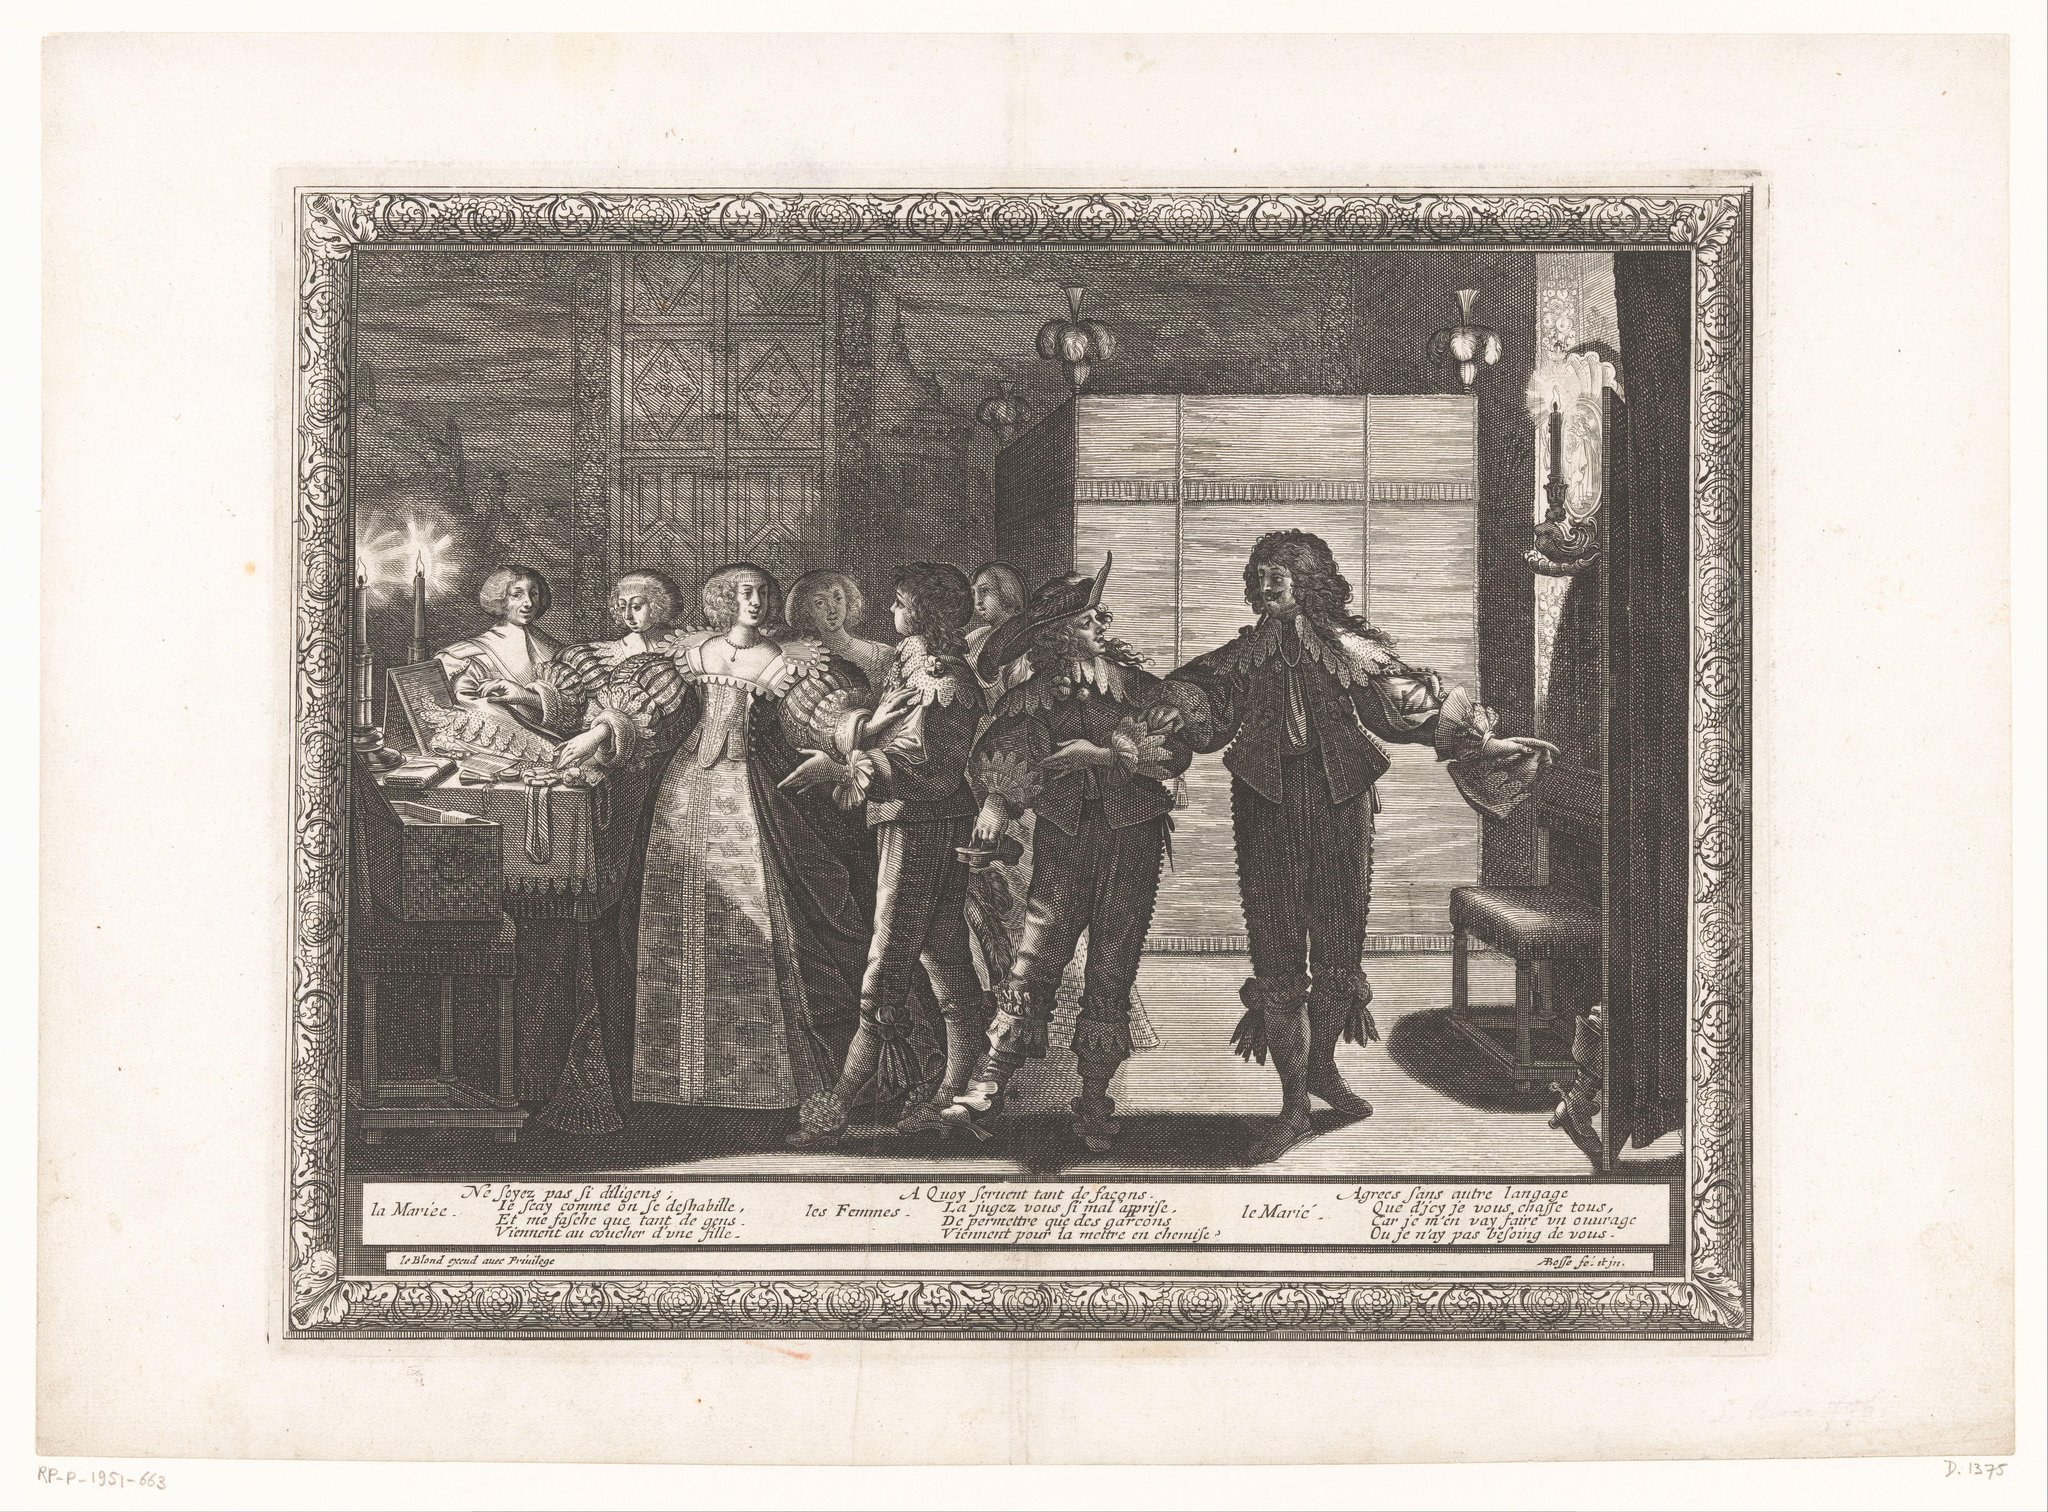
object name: print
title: Le Mariage à la ville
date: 1633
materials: paper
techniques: engraving, etching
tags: (civil) marriage ceremonies, leading the bride to bed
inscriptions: collector's mark: Lugt 2228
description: Maakt deel uit van een serie van zes prenten over het huwelijk.